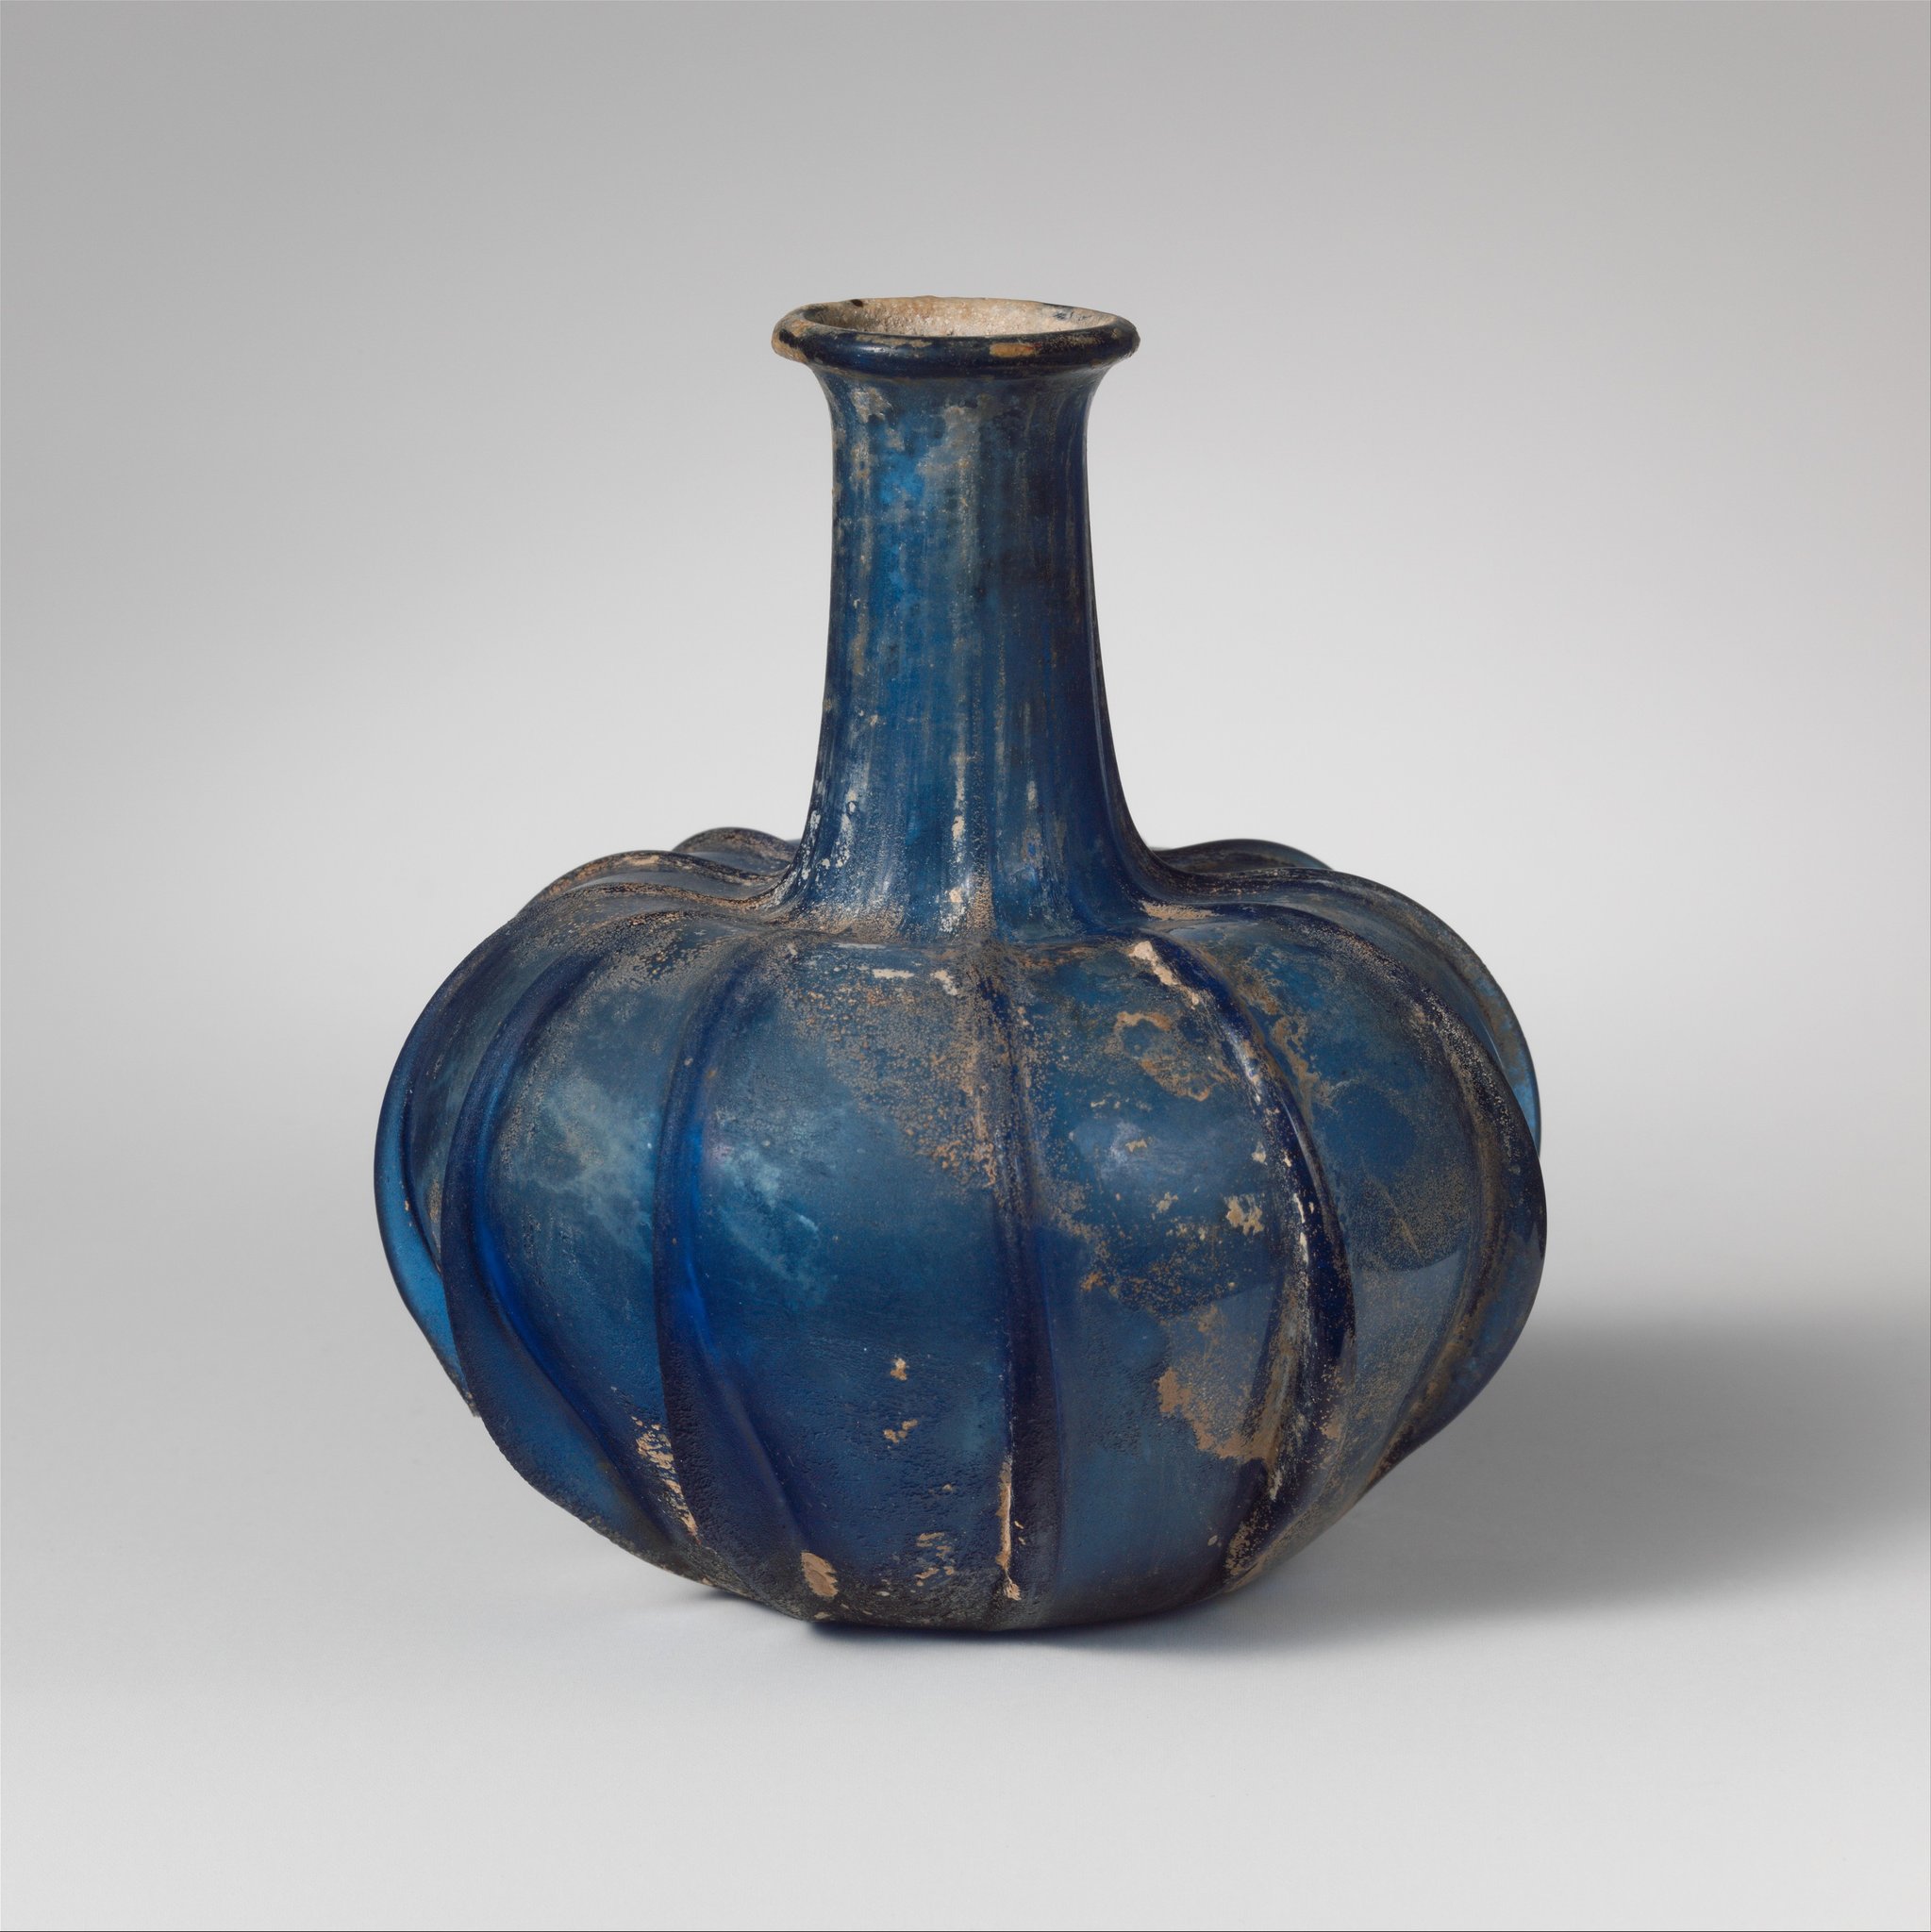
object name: flask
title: Glass ribbed bottle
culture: roman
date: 1-100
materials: glass